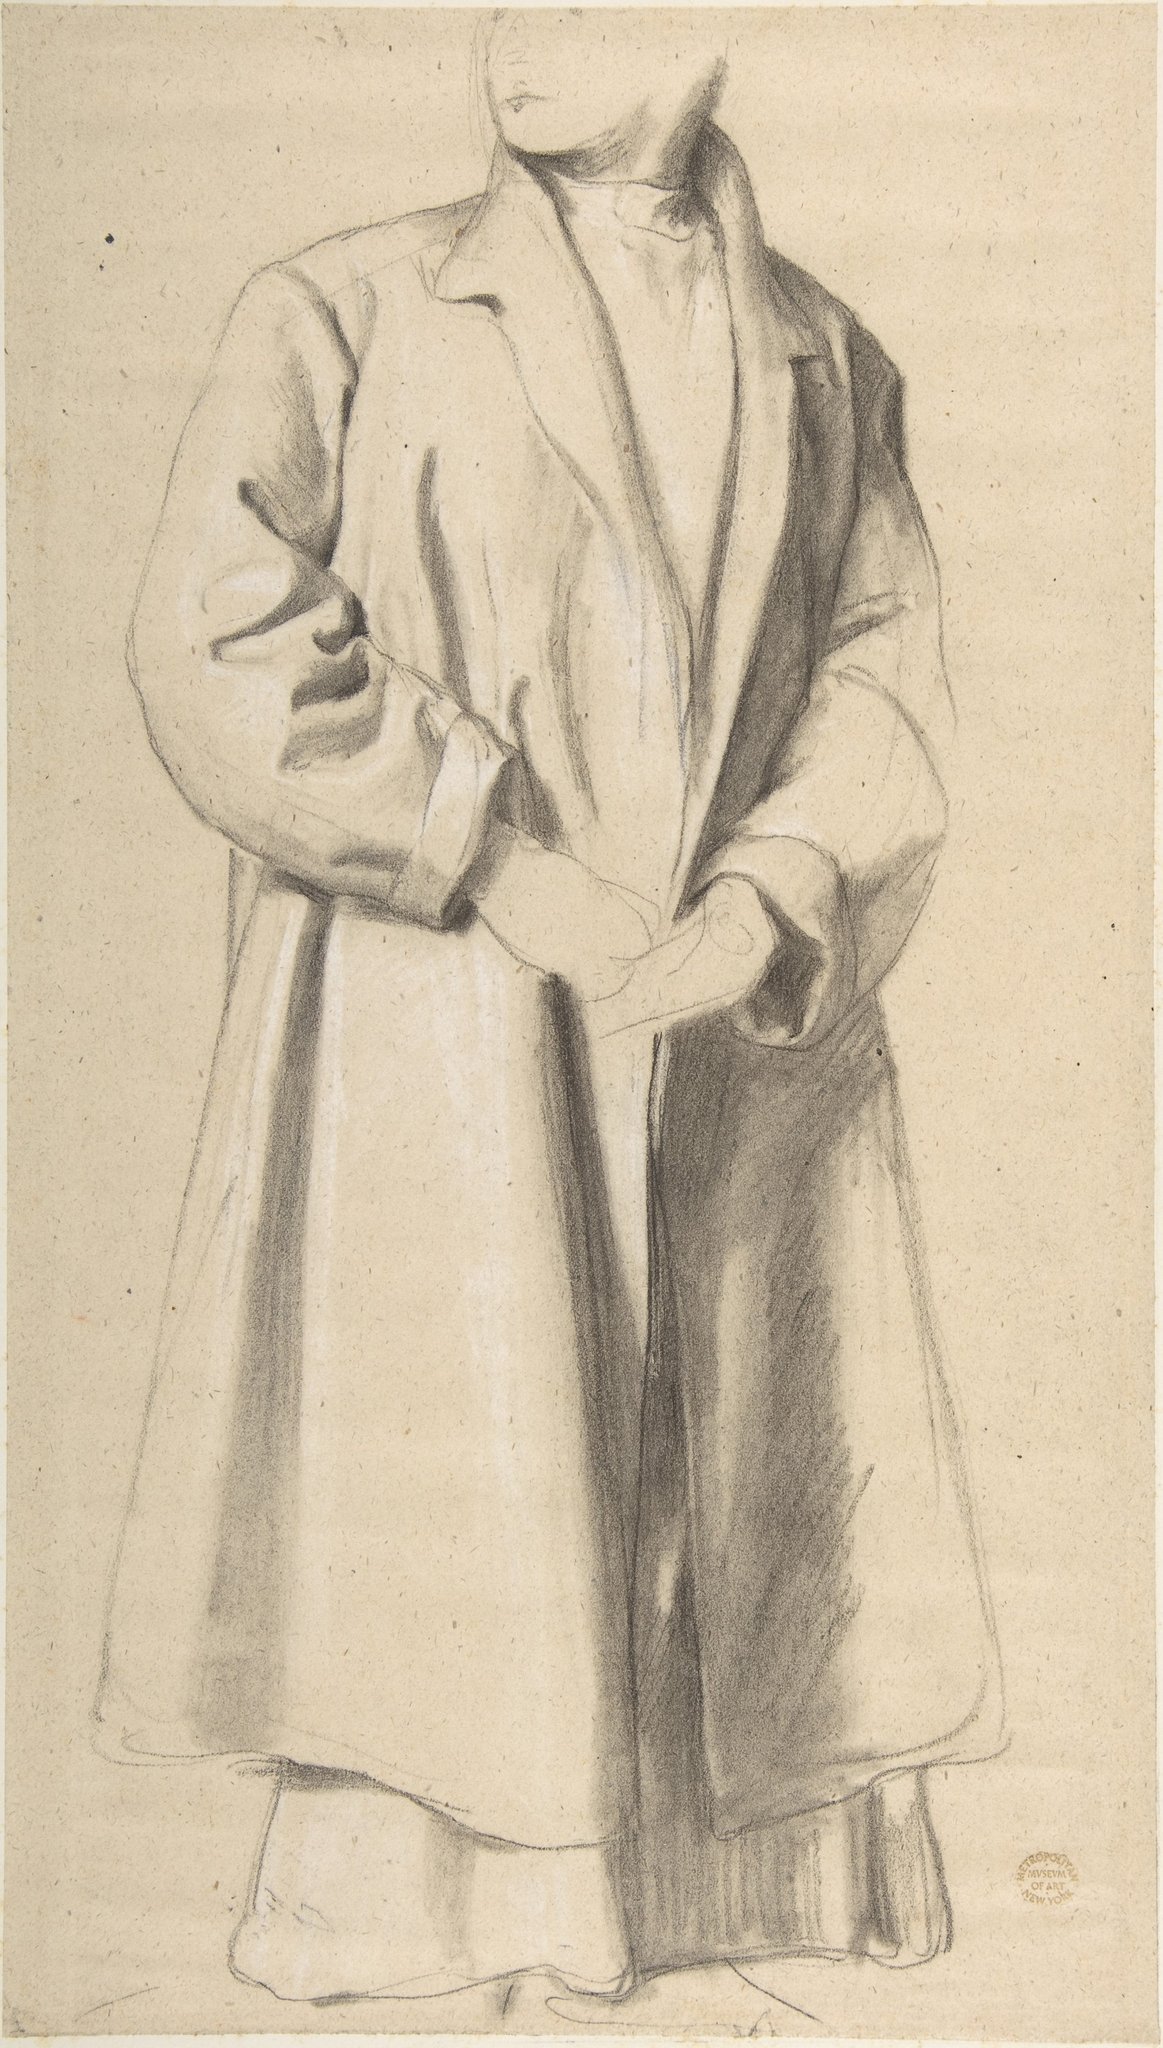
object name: drawing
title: Standing Figure in a Long Coat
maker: romain cazes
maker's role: artist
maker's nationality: french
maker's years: 1808-1881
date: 1828-1881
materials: chalk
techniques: highlighting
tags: human figures